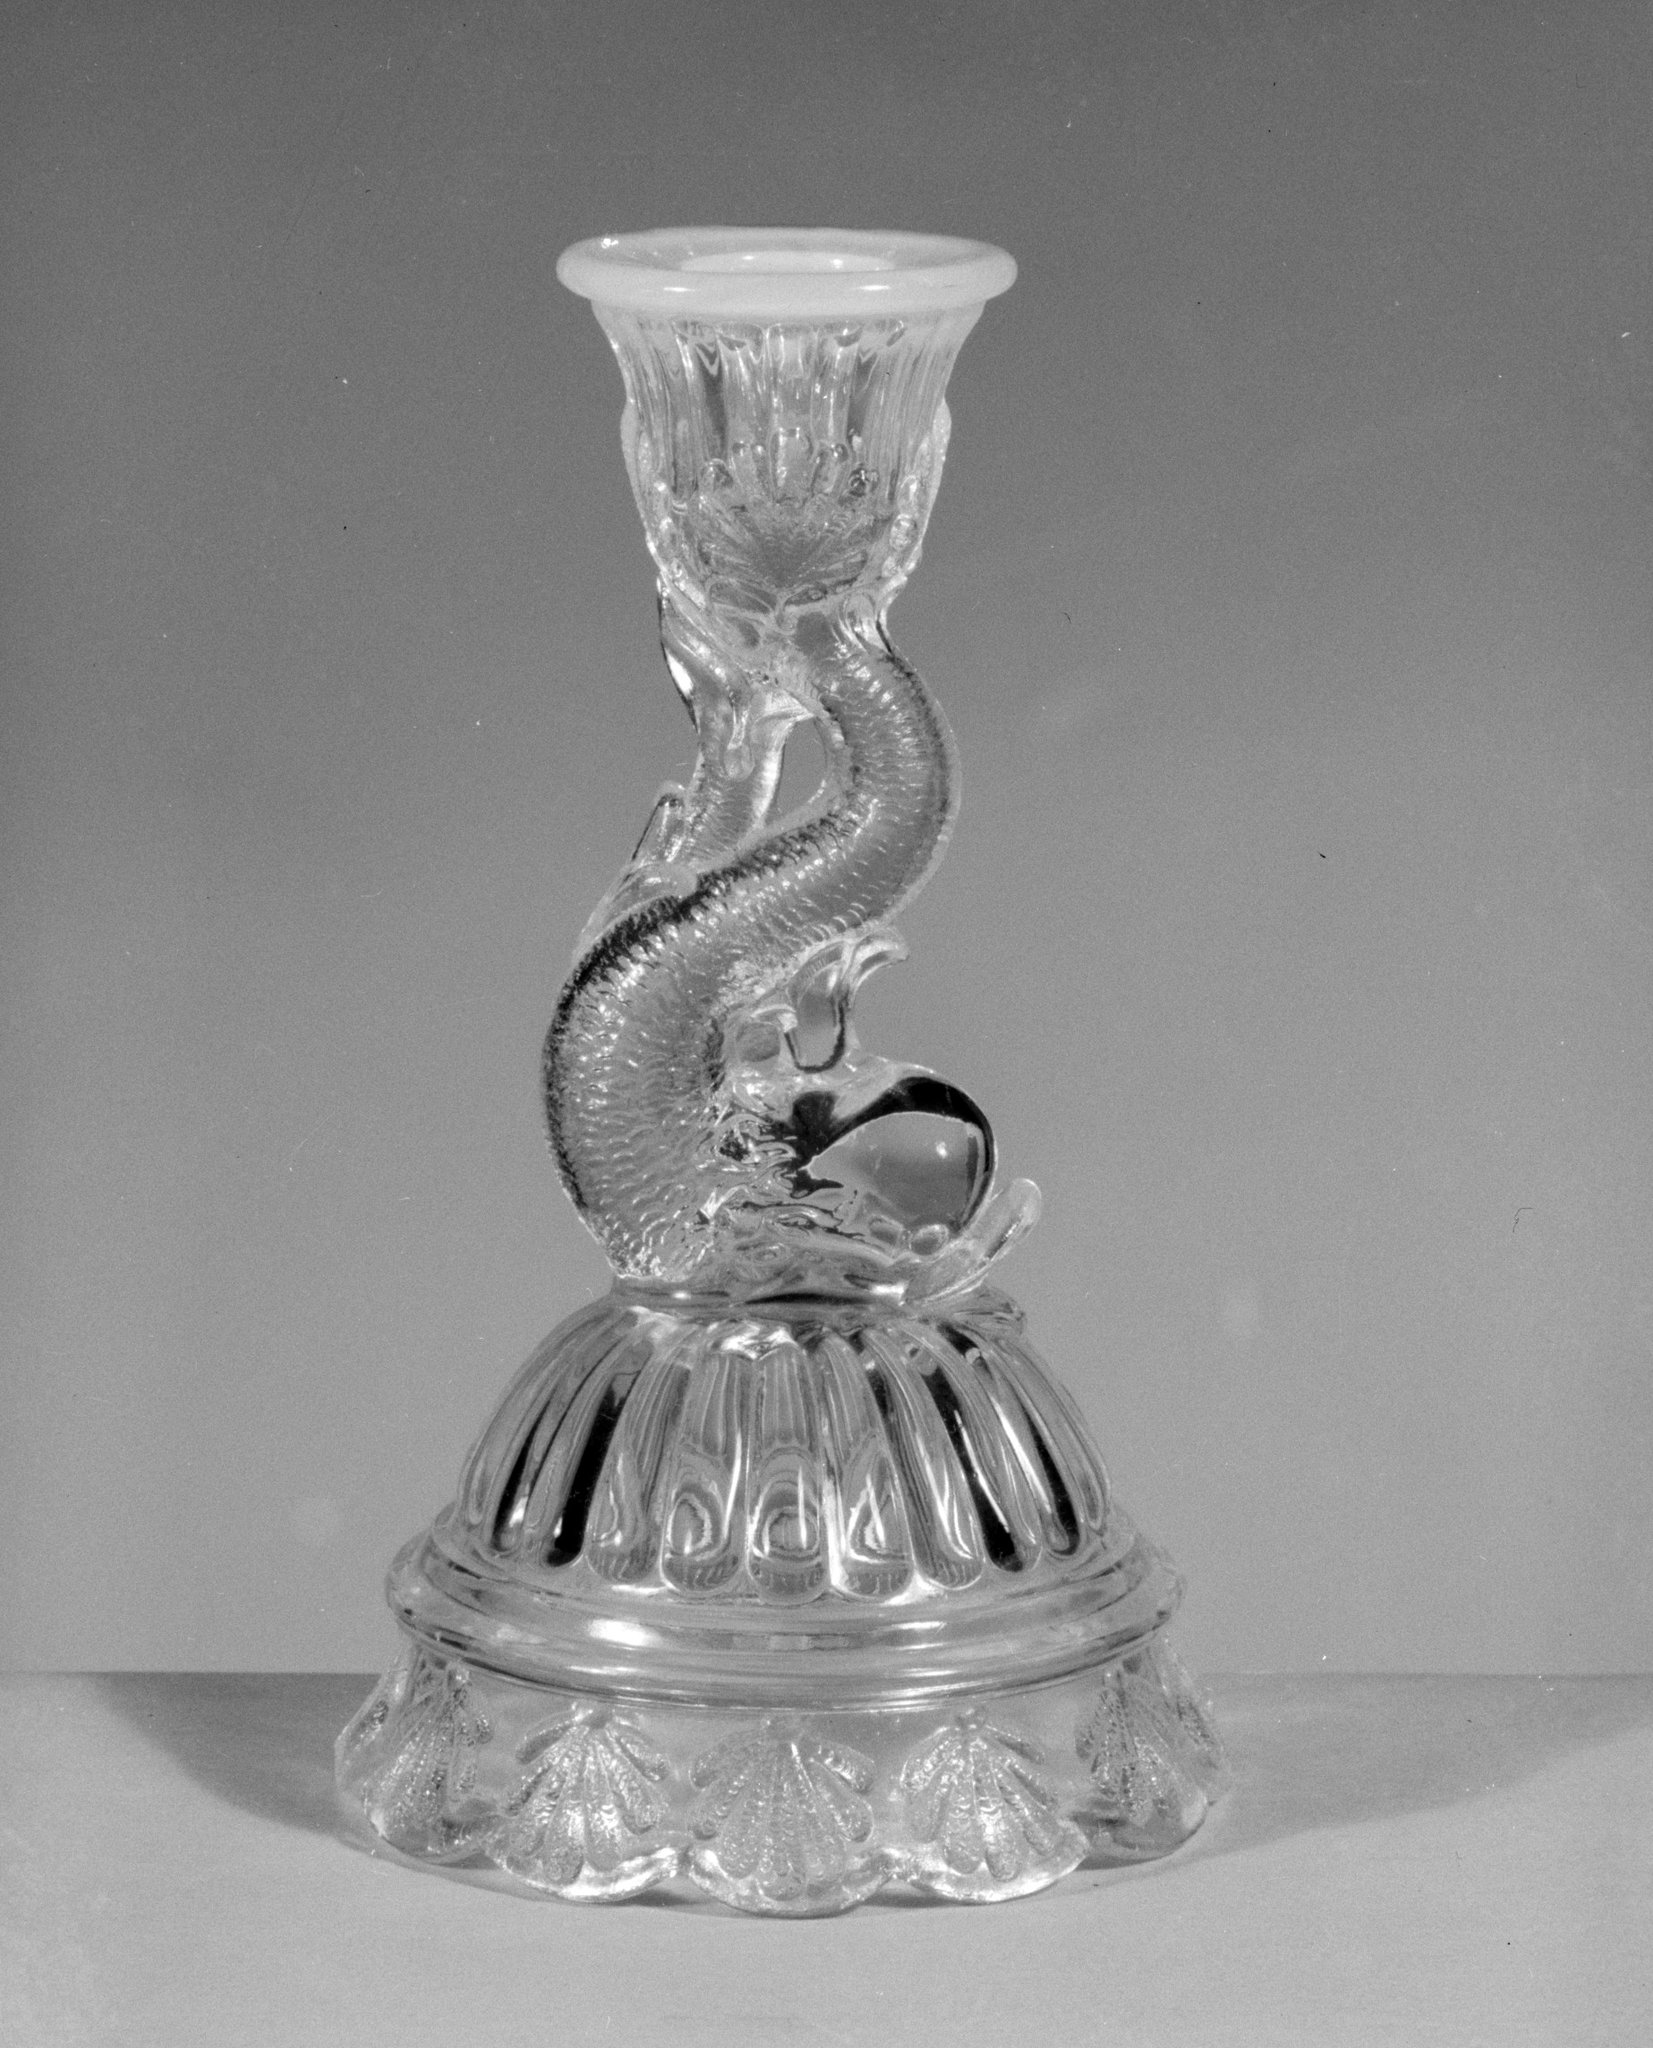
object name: candlestick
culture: american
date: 1875-1900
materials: glass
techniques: pressed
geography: united states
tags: dolphins